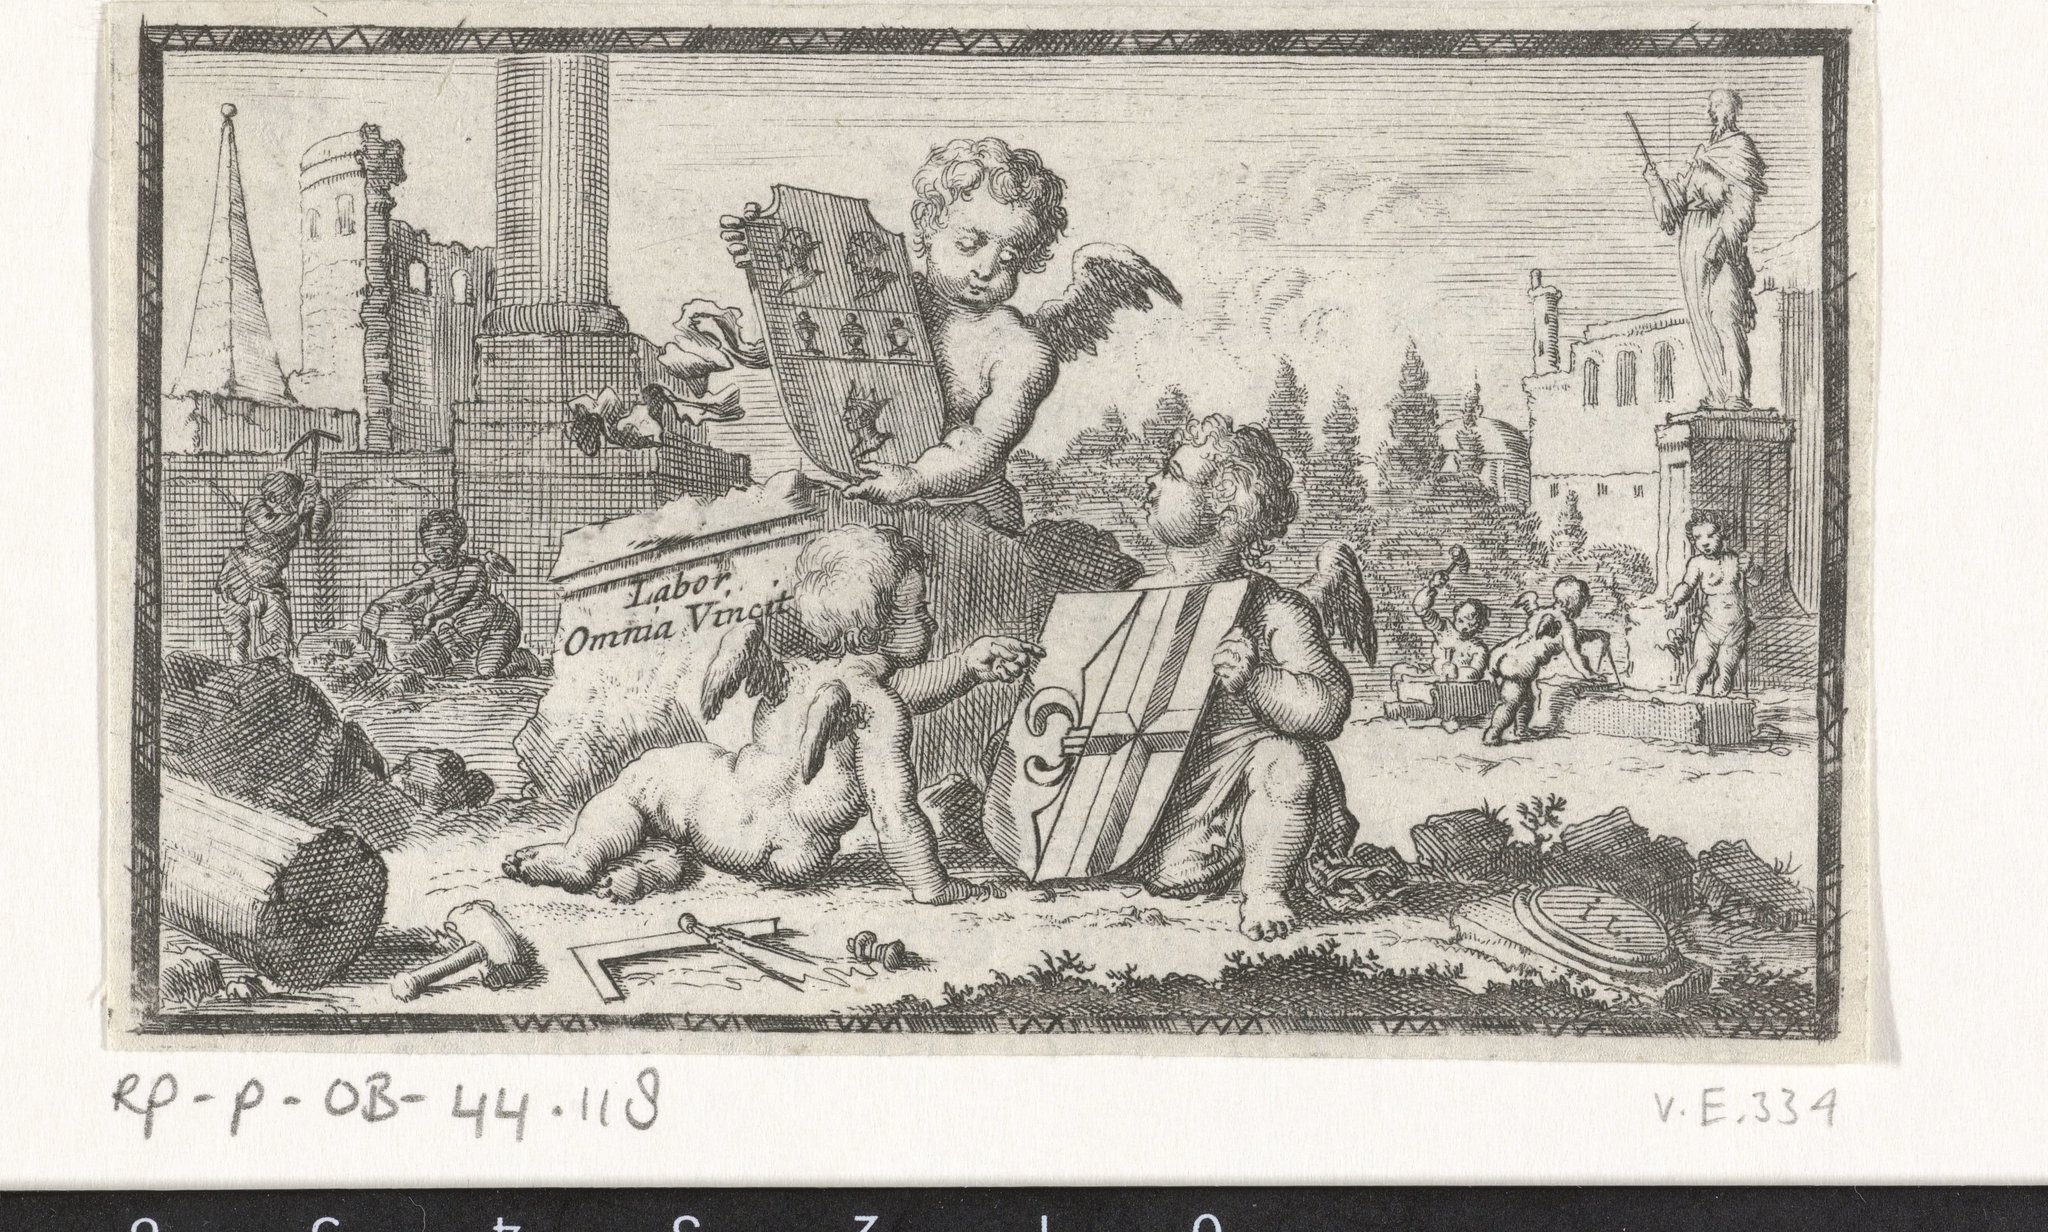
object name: print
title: Labor Omnia Vincit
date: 1681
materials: paper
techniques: etching, letterpress printing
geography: amsterdam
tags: amsterdam, print maker, nicolaes cornelisz. witsen, johannes hudde, coat of arms (as symbol of the state, etc.) (+ city; municipal), cupids: 'amores', 'amoretti', 'putti'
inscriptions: collector's mark: Lugt 2228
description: Illustratie opgenomen in: Goeree, Wilhelmus. D'algemeene bouwkunde, volgens d'antyke en hedendaagse manier. Amsterdam: Willem Goeree, 1681.